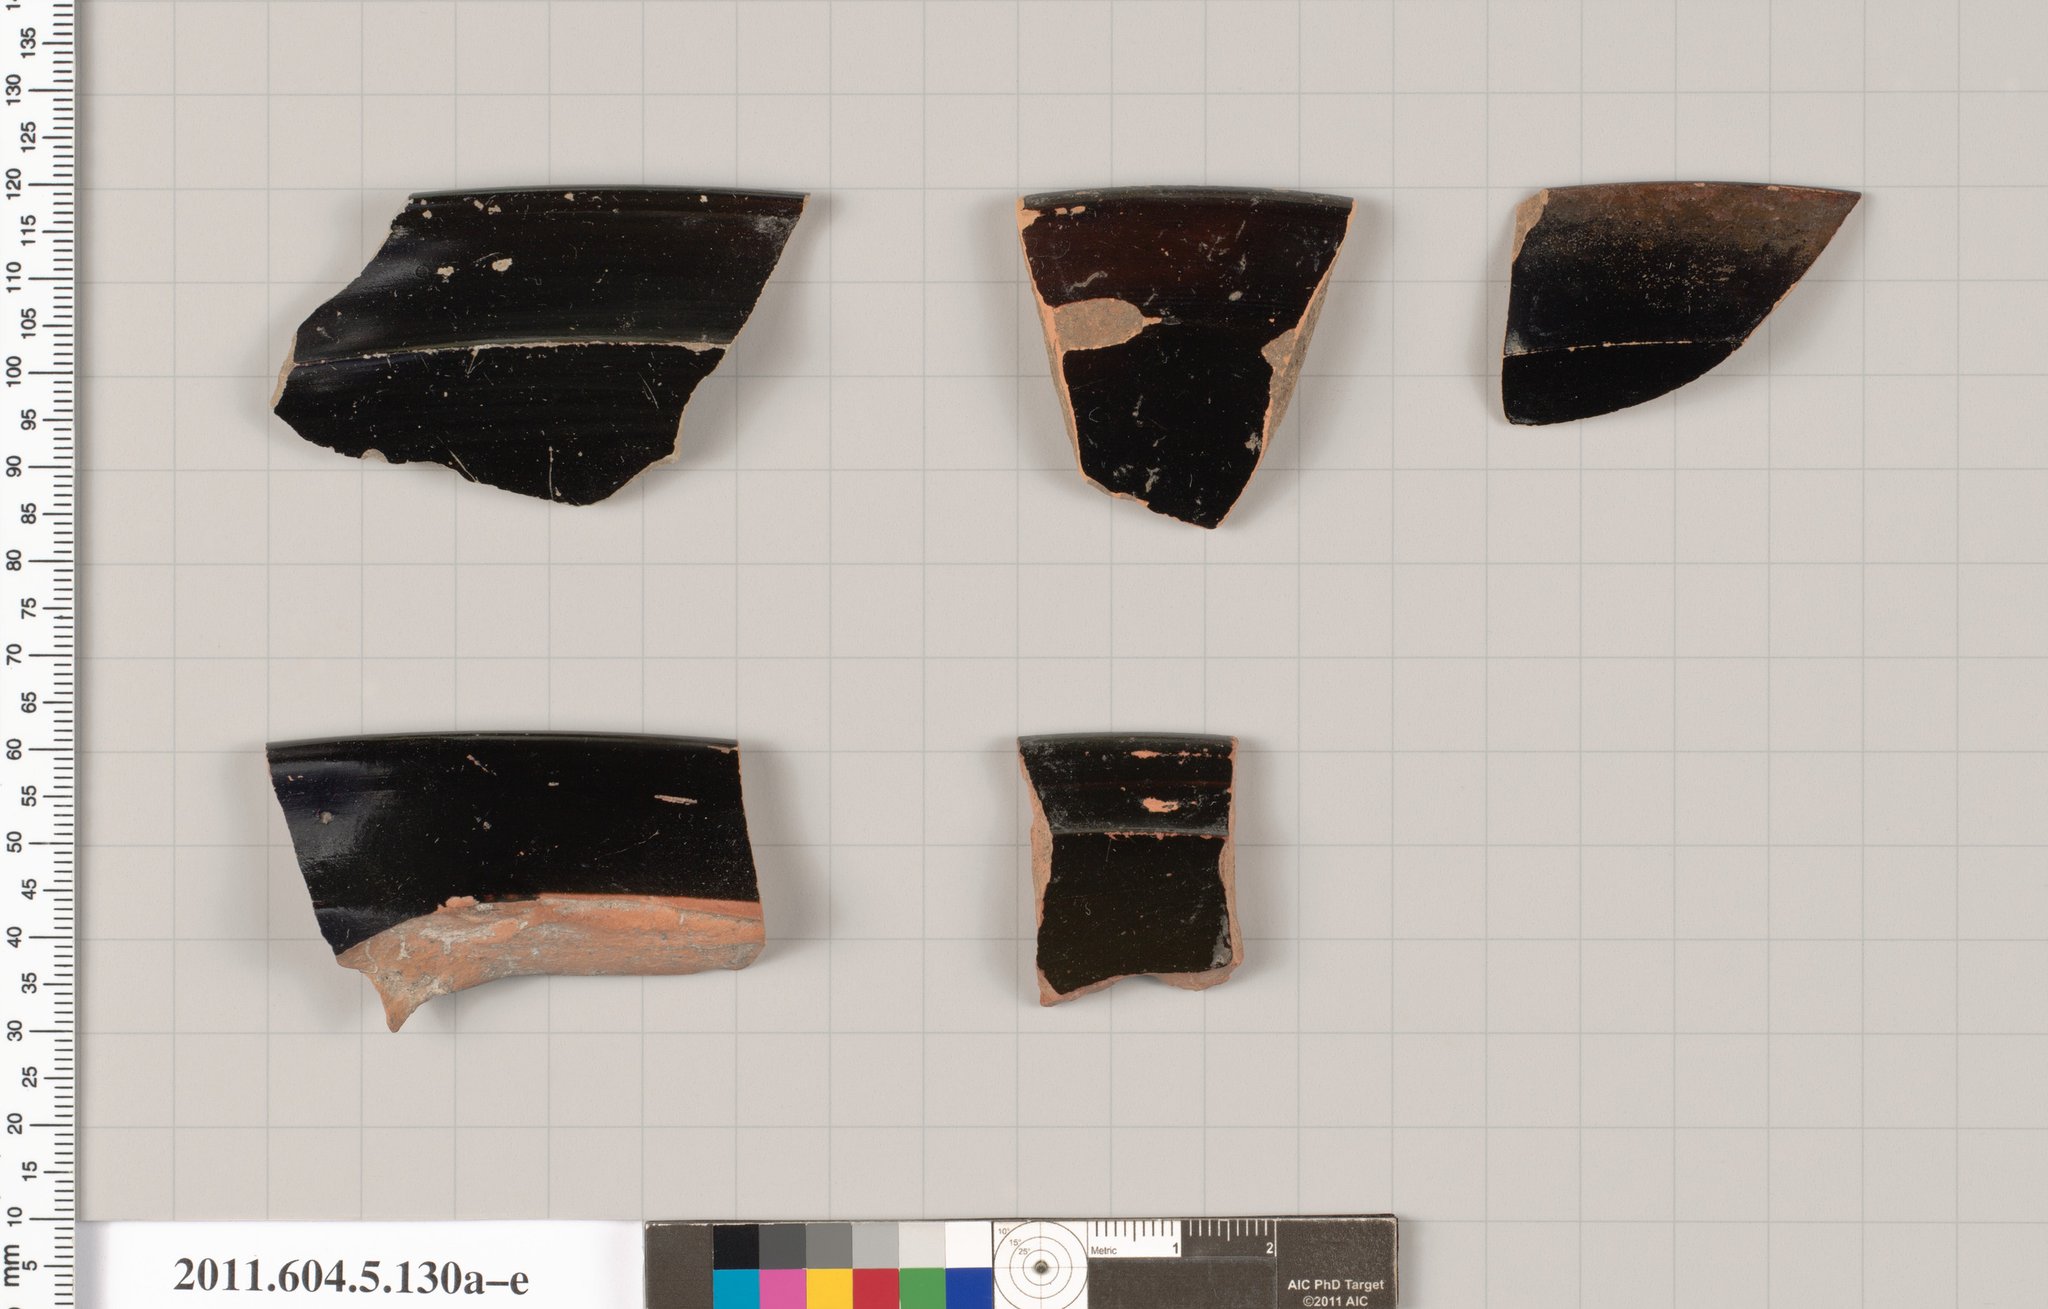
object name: kylix fragment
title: Terracotta rim fragments of stemless kylikes (drinking cups)?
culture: greek, attic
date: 470-450 BCE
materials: terracotta